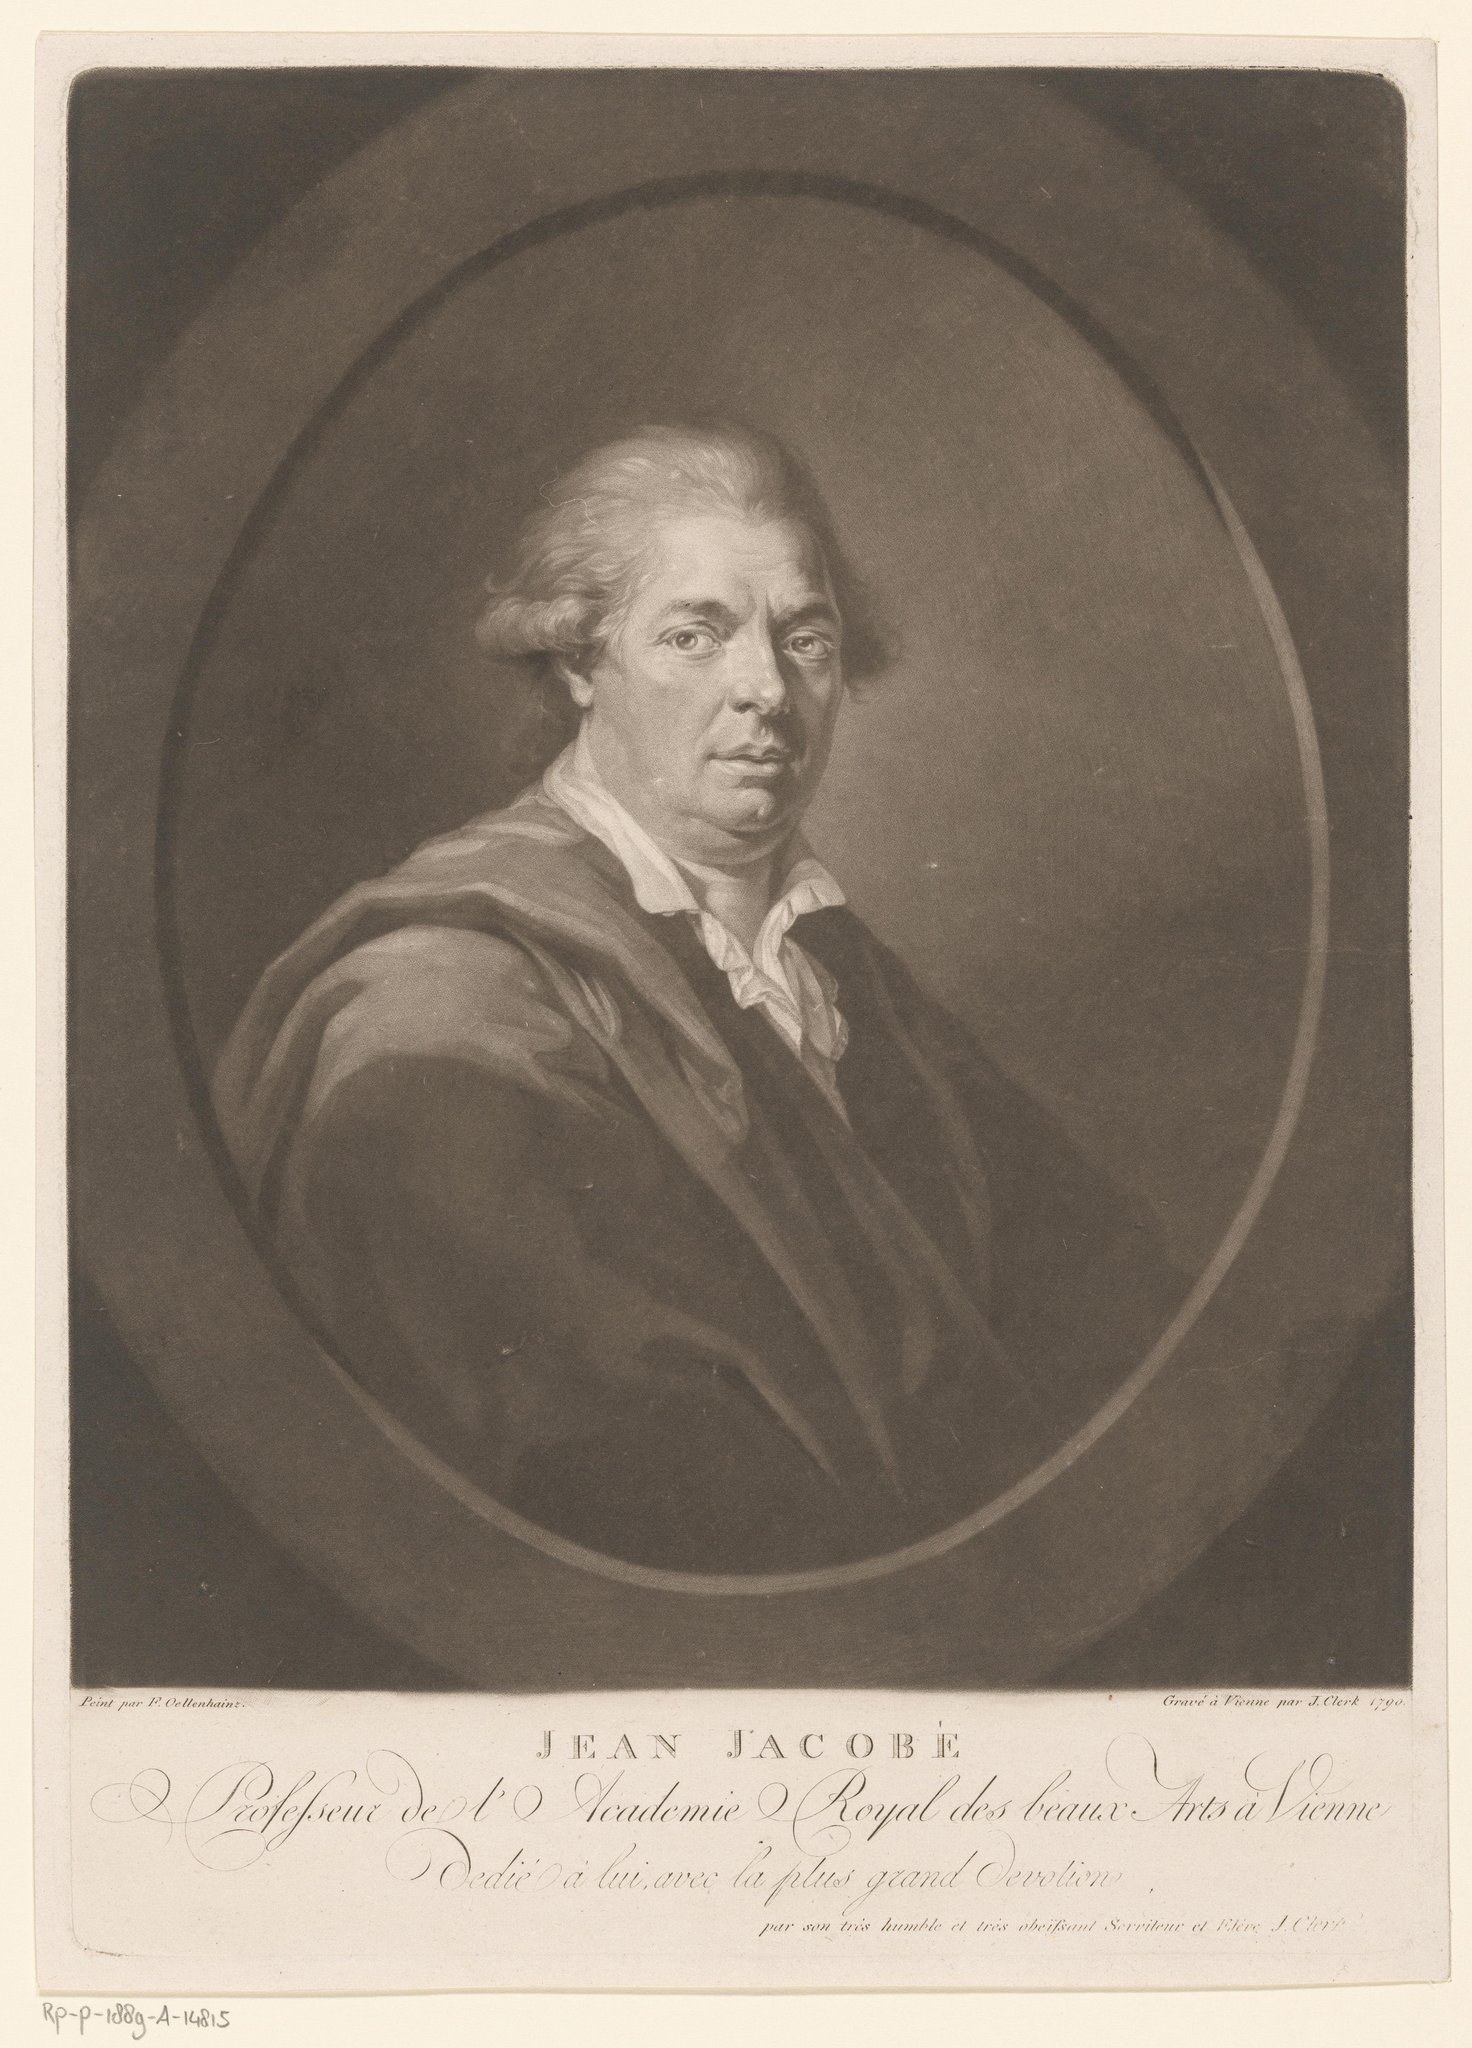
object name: print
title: Portret van Johann Alexander Gottfried Jacobé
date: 1790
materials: paper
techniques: mezzotint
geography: vienna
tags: vienna, historical persons, portrait, self-portrait of graphic artist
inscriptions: collector's mark: Lugt 2228